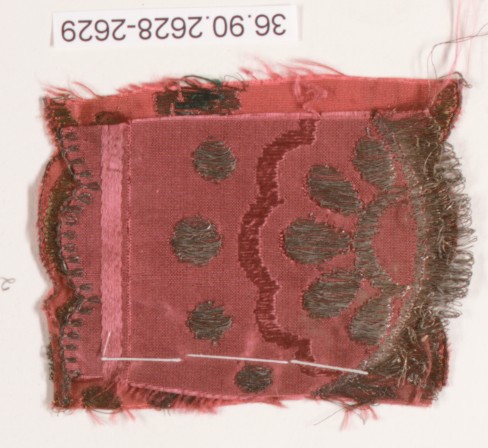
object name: ribbon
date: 1801-1900